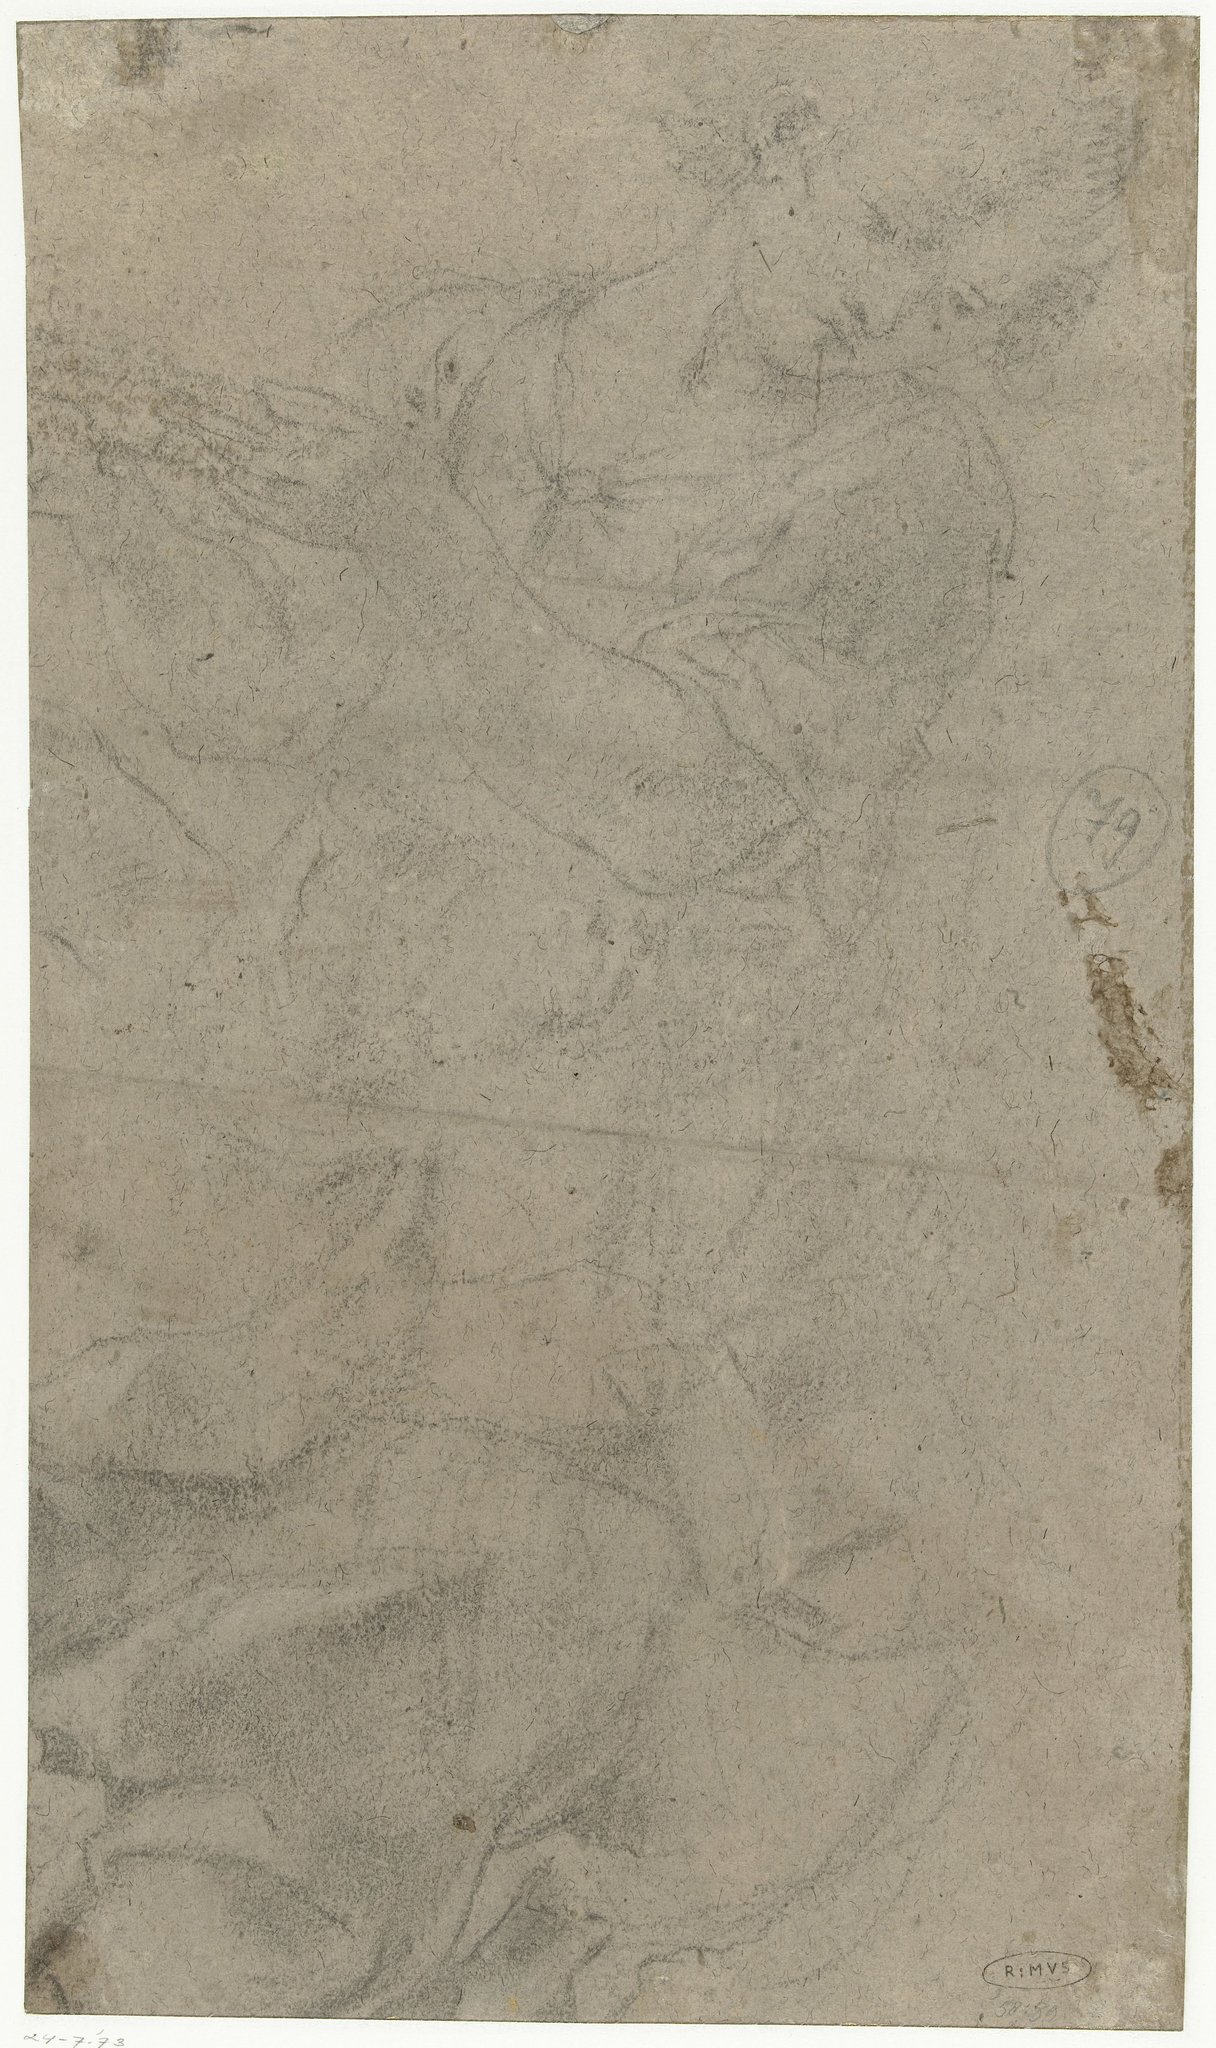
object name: drawing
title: Studie van een zwevende engel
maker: domenichino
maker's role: draughtsman, painter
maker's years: 1581-1641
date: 1613-1623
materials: chalk, paper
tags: angels